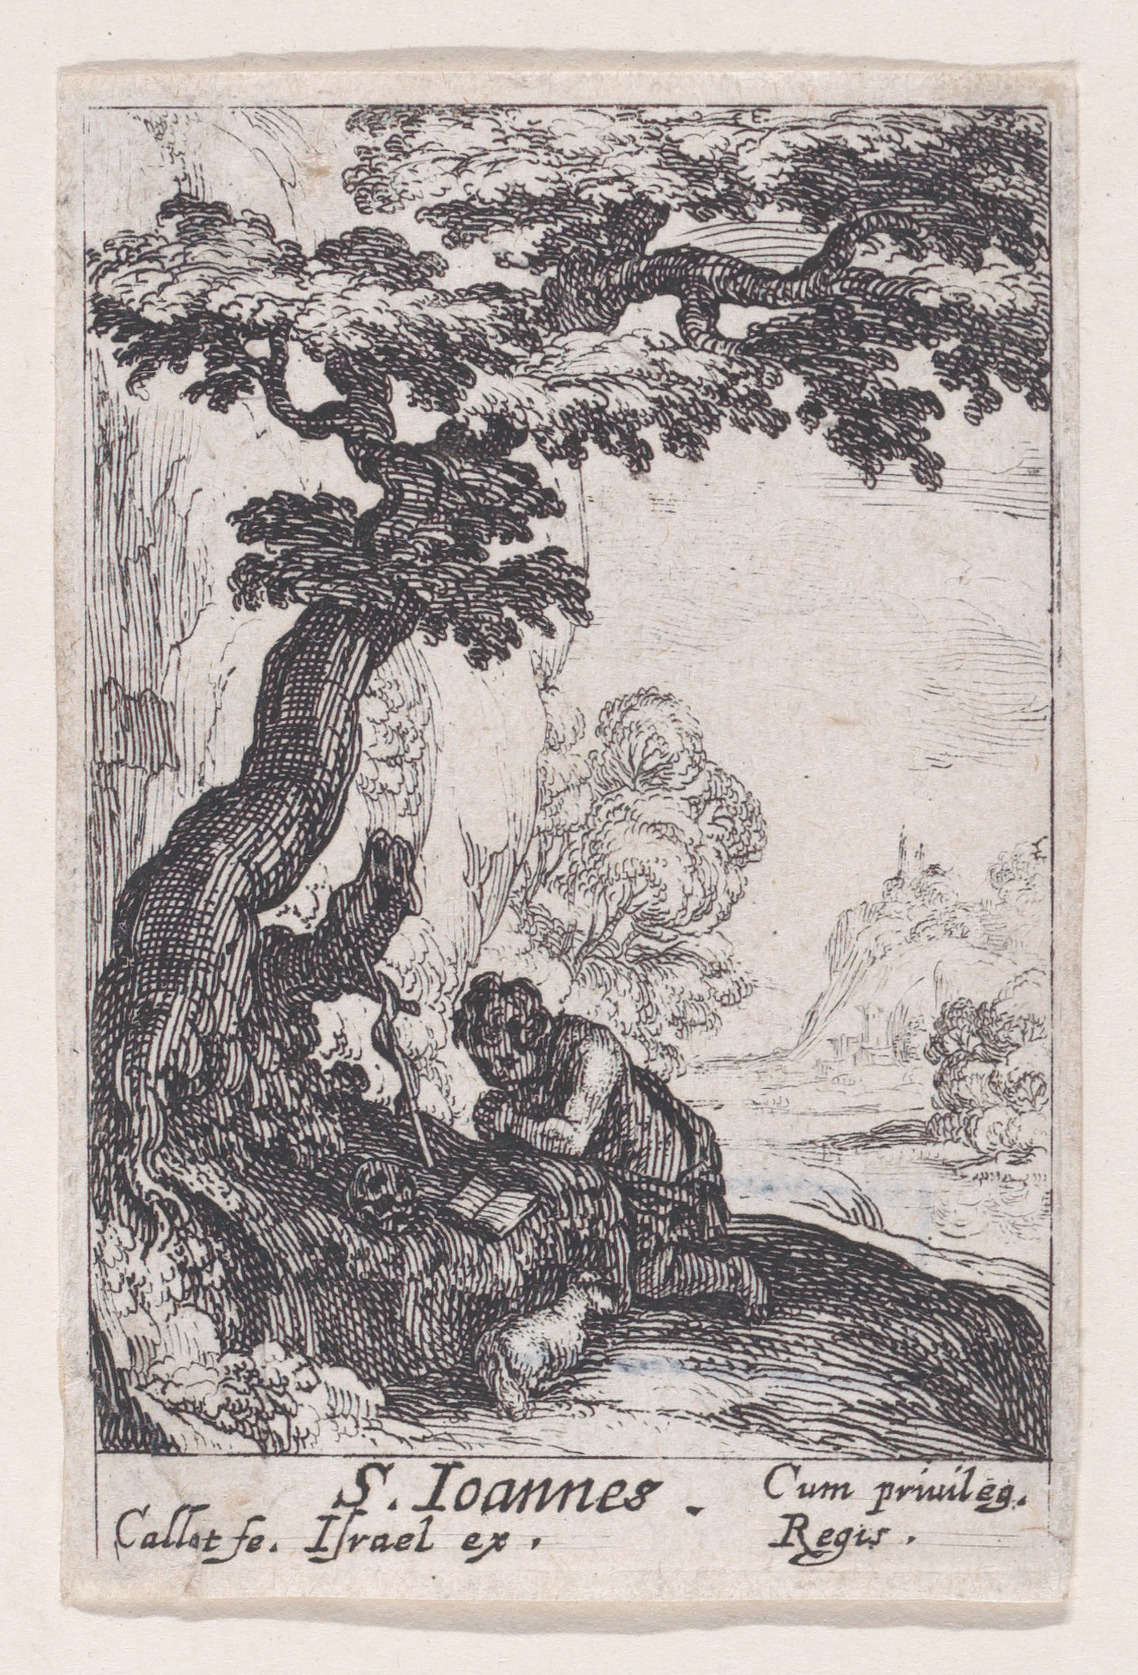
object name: print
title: St. John the Baptist, from "Les Pénitents et Pénitentes" (The Penitents)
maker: jacques callot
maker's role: artist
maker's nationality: french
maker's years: 1592-1635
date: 1632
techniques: etching